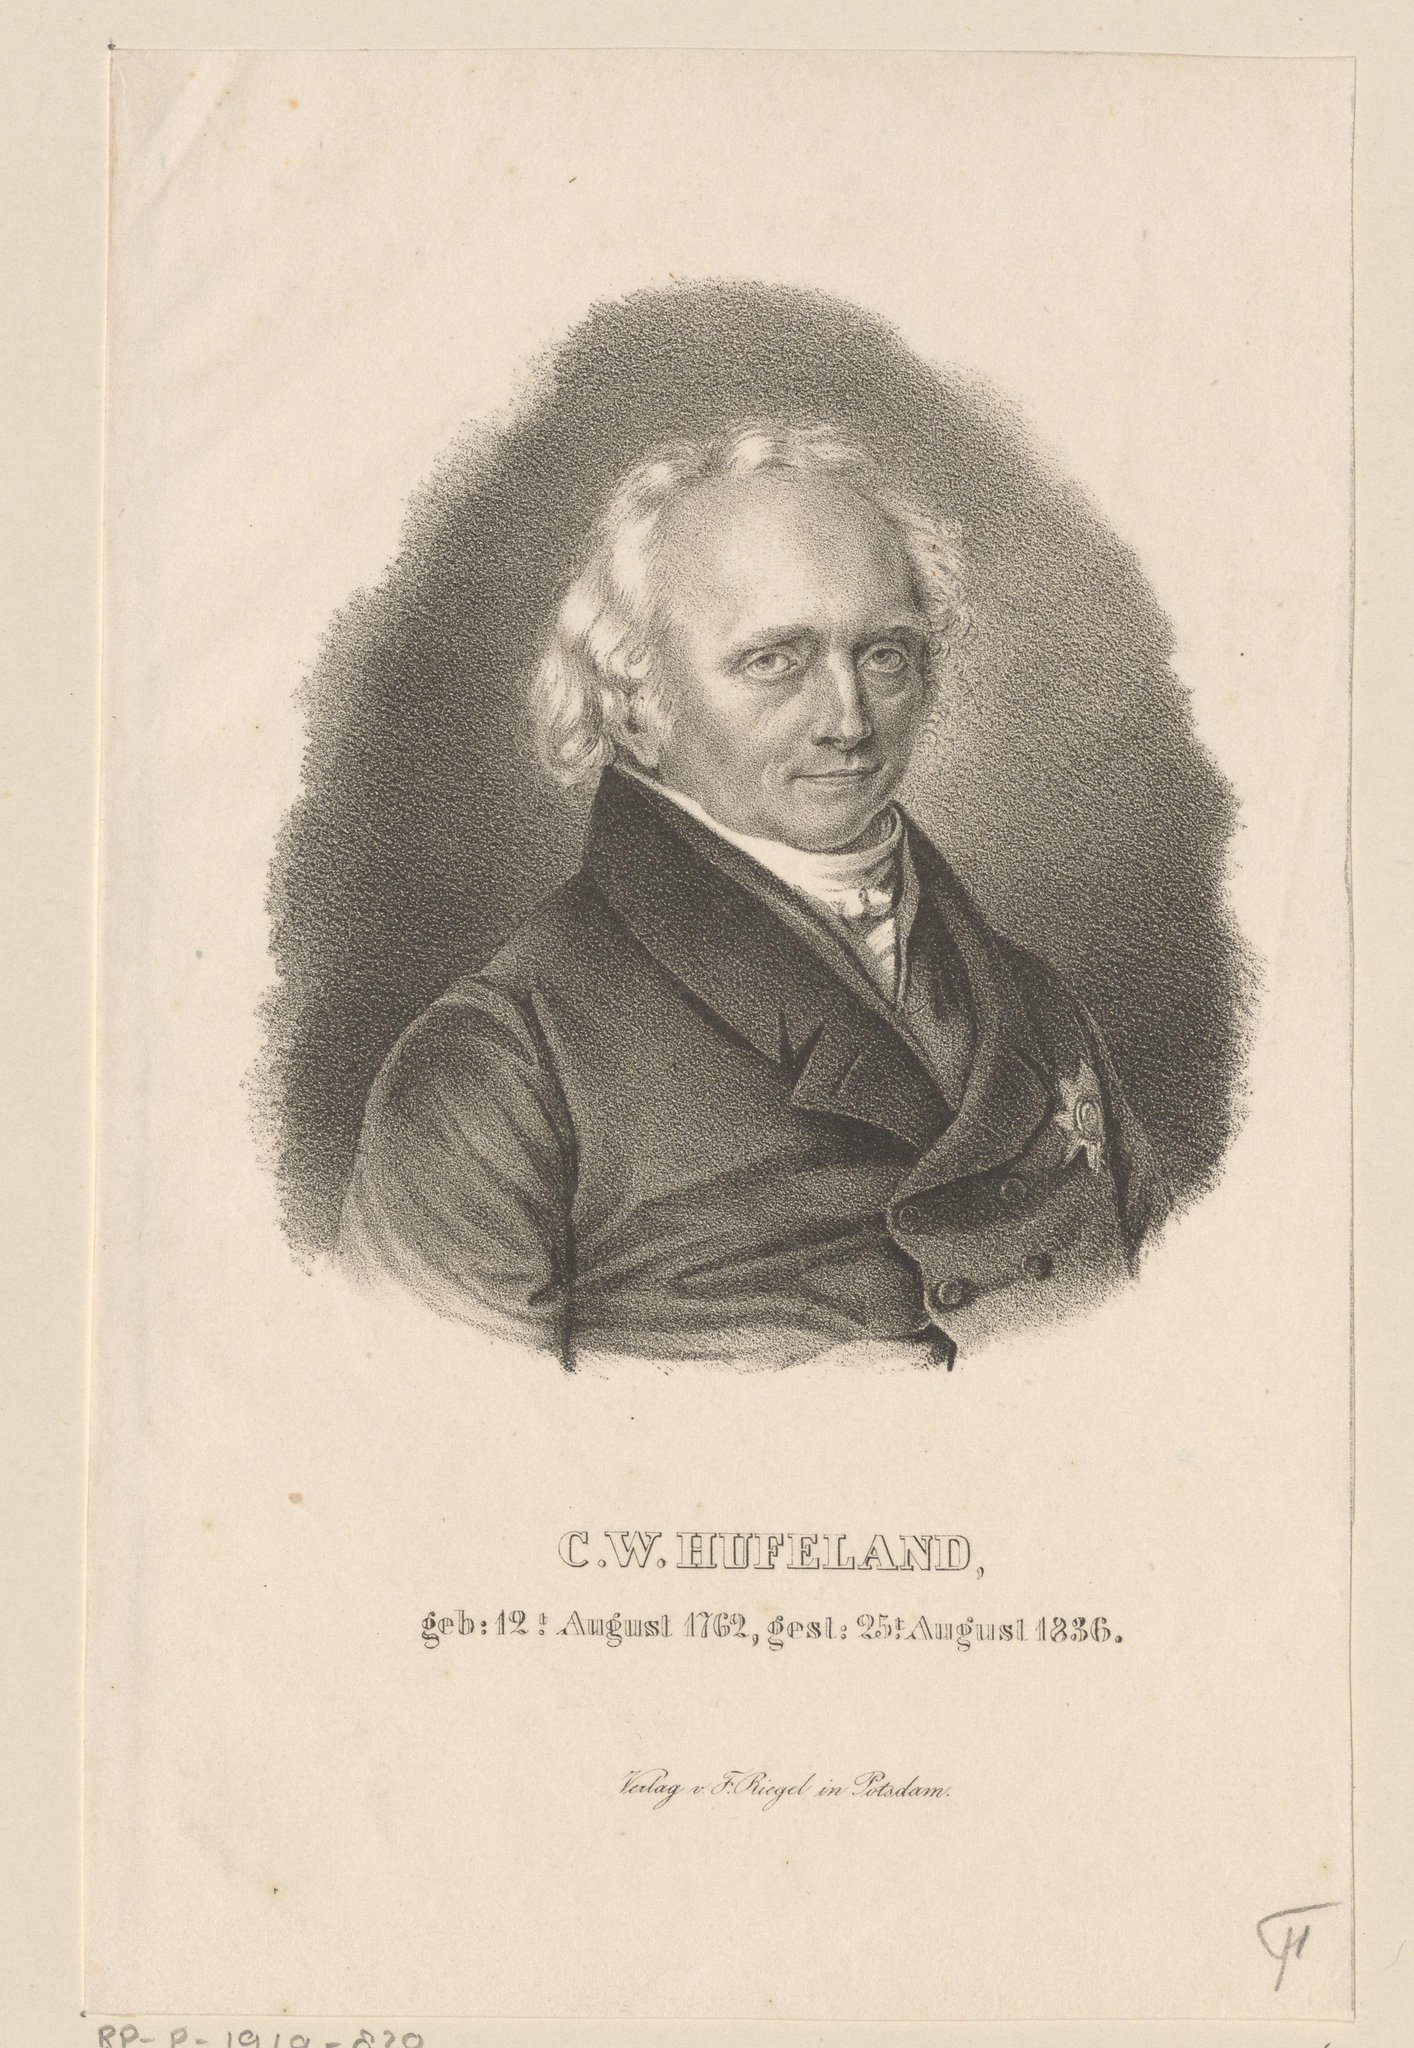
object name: print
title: Portret van Christoph Wilhelm von Hufeland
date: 1837-1853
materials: paper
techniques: lithograph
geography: potsdam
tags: historical persons, armorial bearing, heraldry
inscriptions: collector's mark: Lugt 2228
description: Prent gebruikt in: Augustin, Friedrich Ludwig. Dr. Chr. Wilh. Hufelands (...) Leben und Wirken für Wissenschaft, Staat und Menschheit. Potsdam: Ferdinand Riegel, 1837.